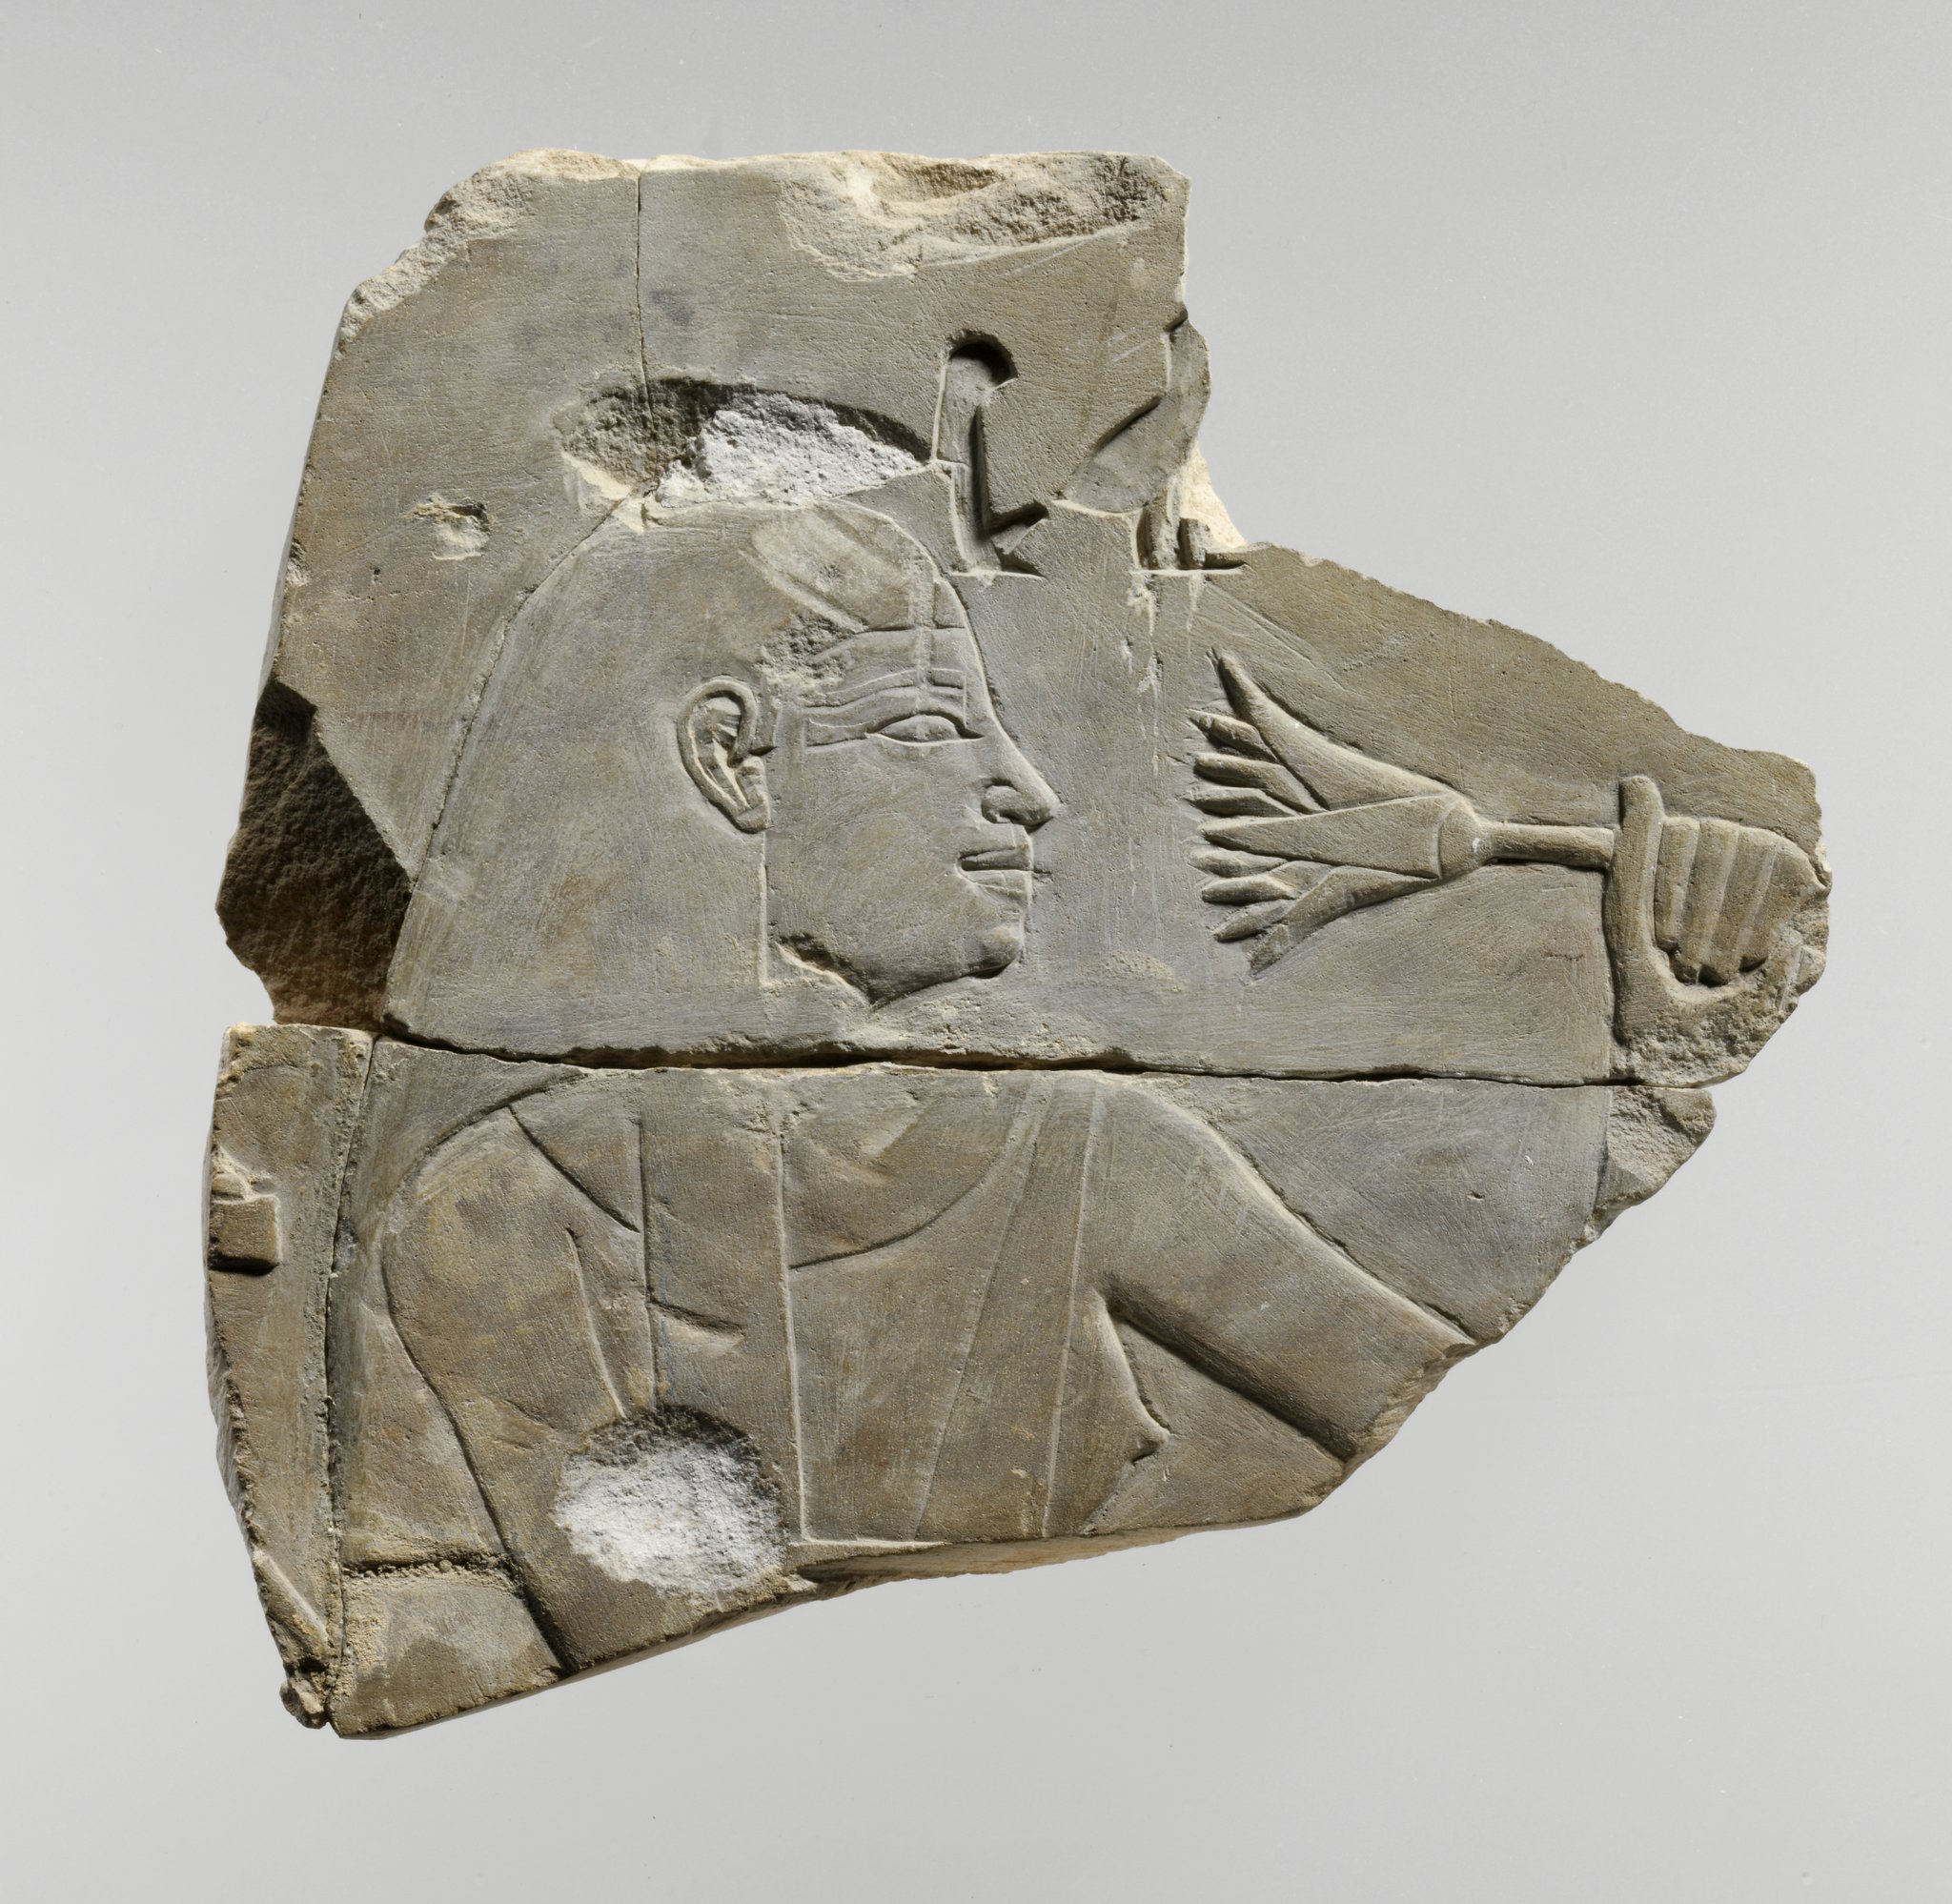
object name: relief, tomb of heri tt 12, woman, mesu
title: Mesu Smelling a Lotus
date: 1525-1504 BCE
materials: limestone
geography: egypt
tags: women,lotuses